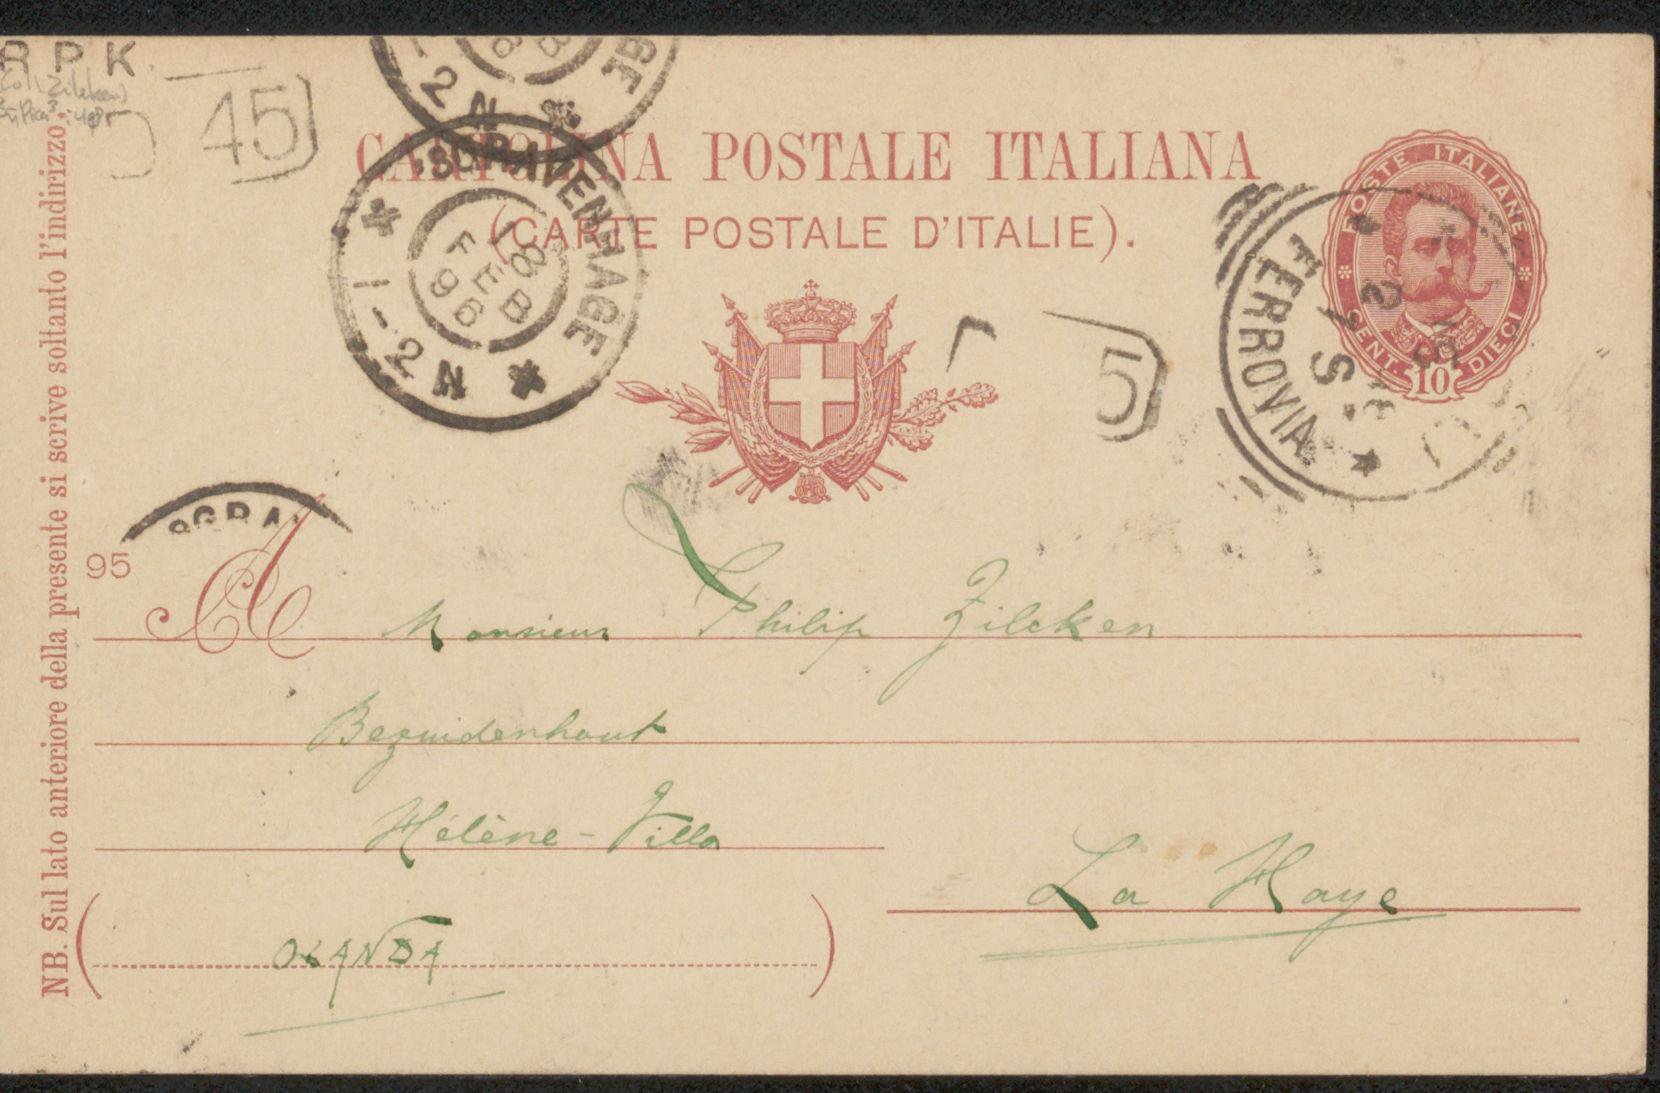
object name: postcard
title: Briefkaart aan Philip Zilcken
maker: vittorio pica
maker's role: criticus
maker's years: 1864-1930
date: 1895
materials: cardboard, ink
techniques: pen, writing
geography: naples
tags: draughtsman, philip zilcken, literature ~ arts, printed matter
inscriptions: collector's mark: ‘RPK’